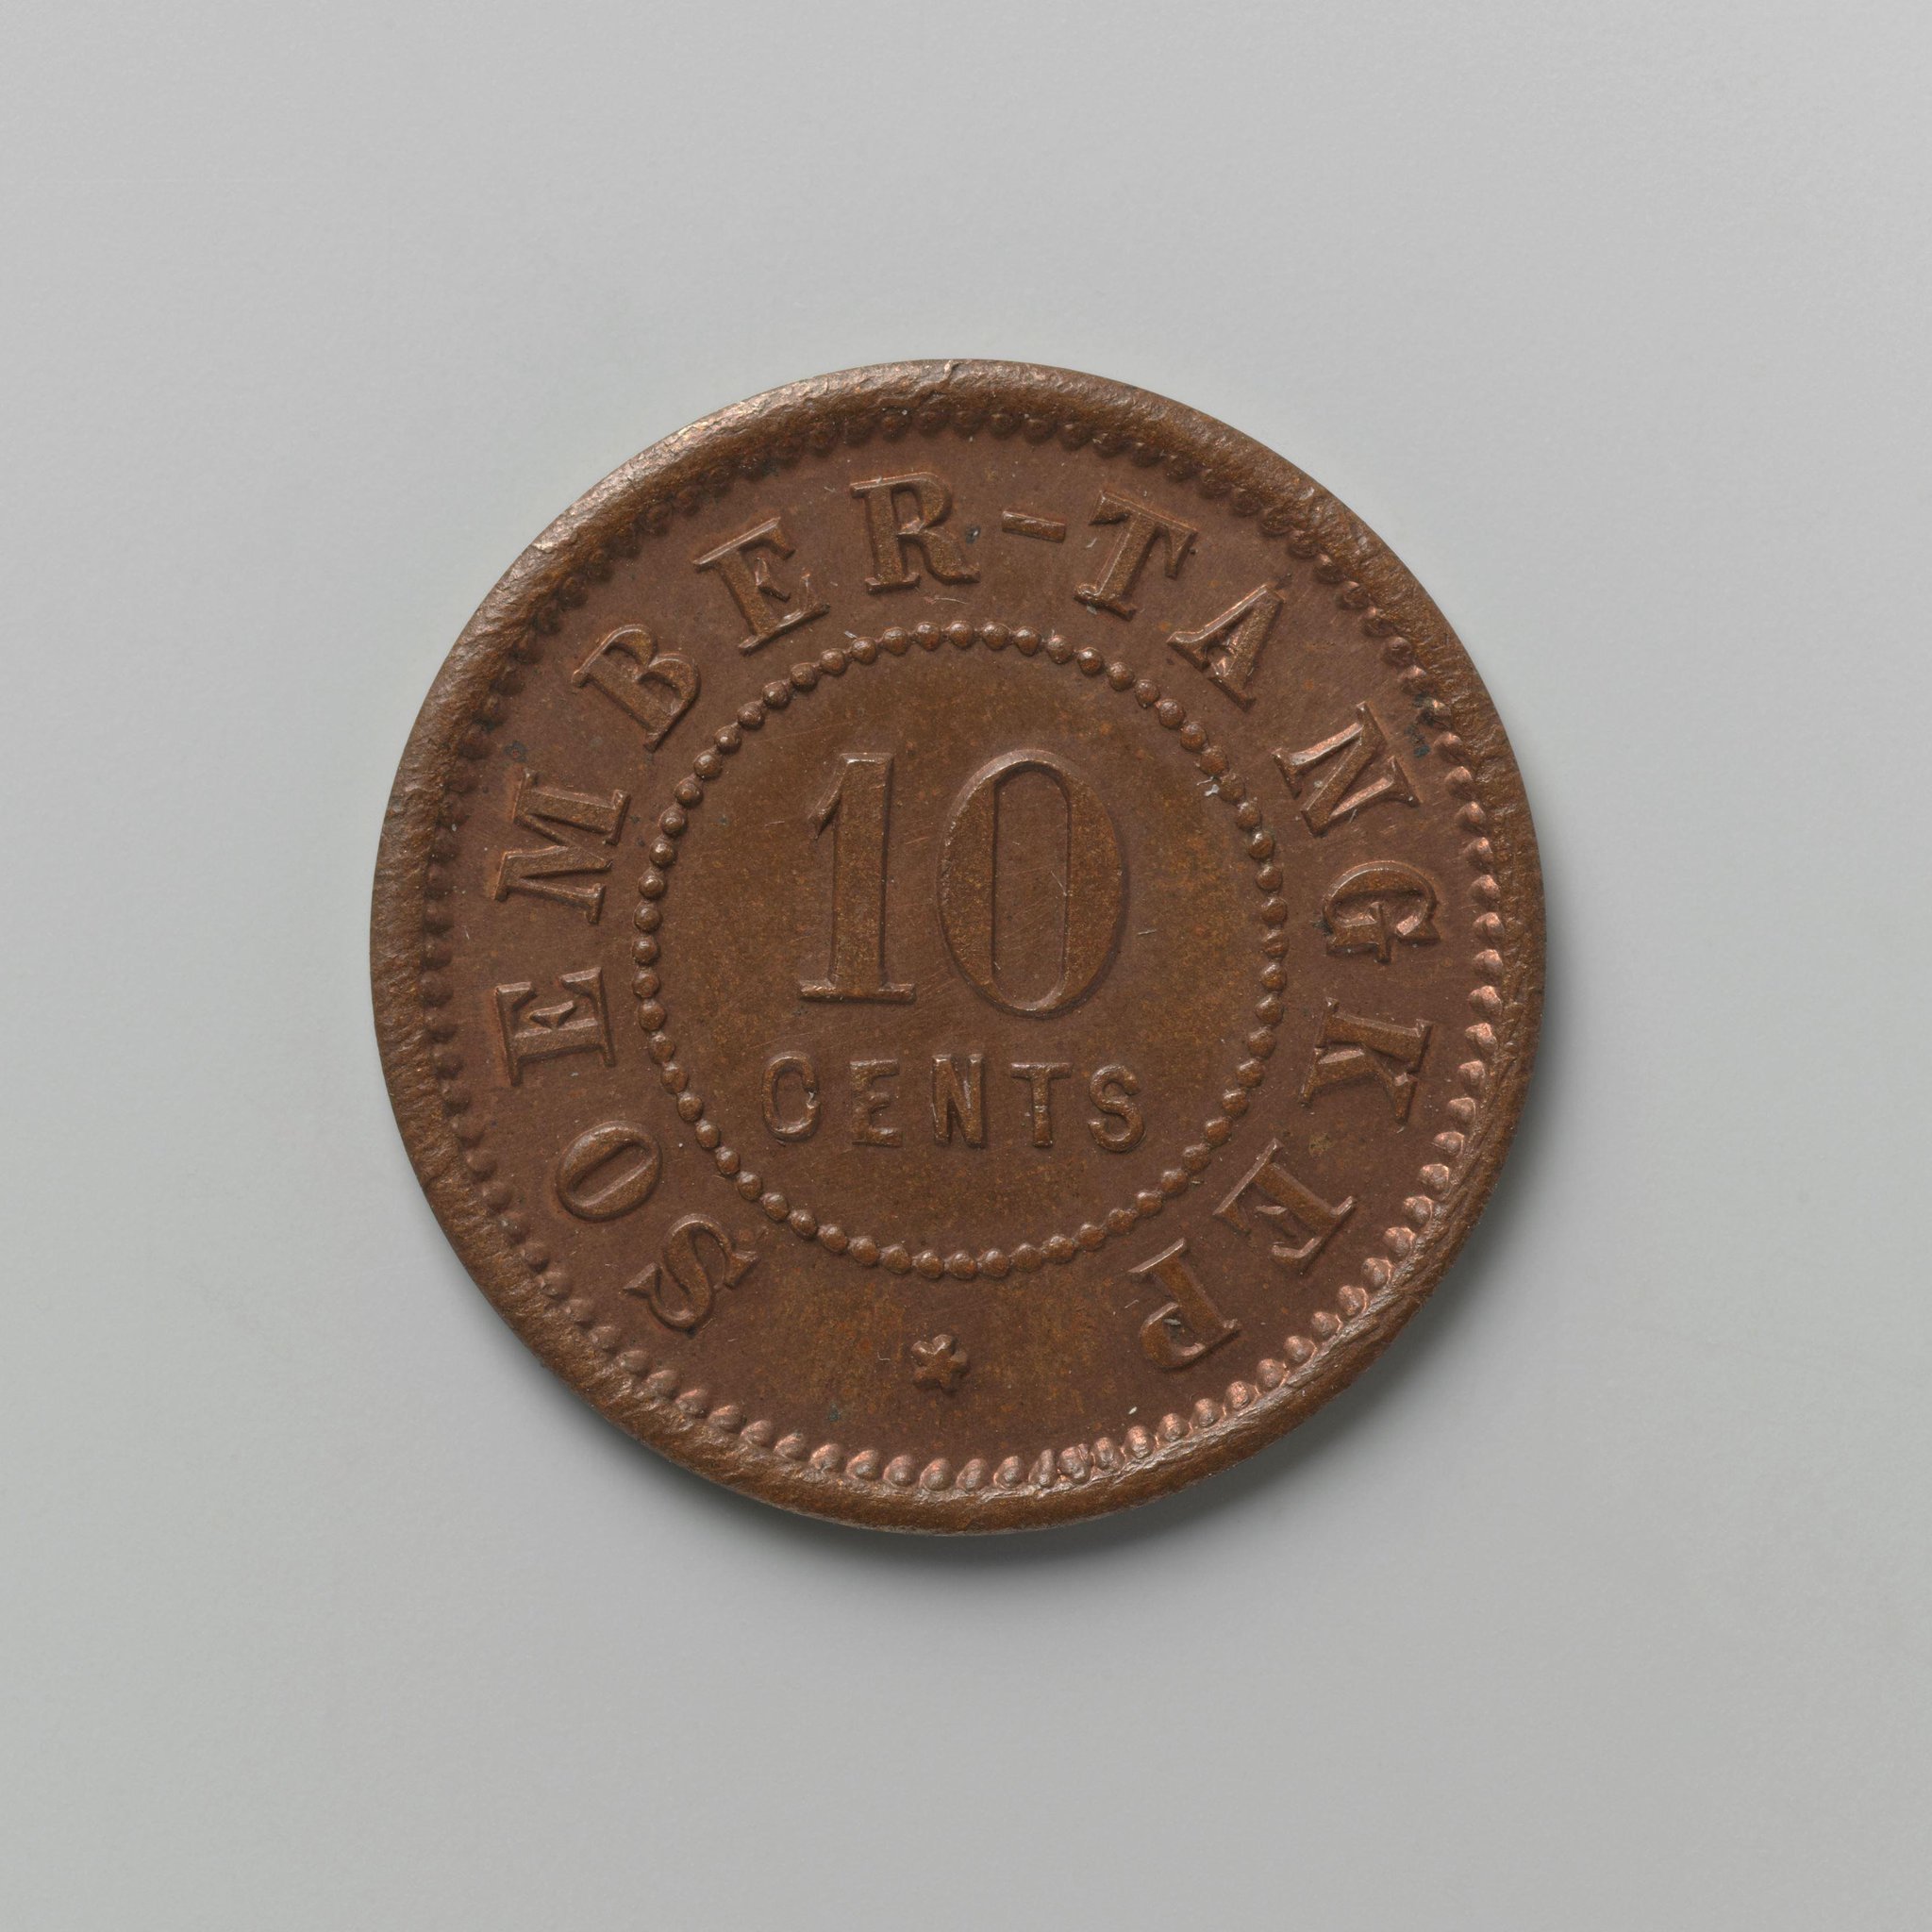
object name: monetary token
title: Tien cents voor plantage Soember-Tangkep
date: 1875-1925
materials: copper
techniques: striking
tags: plantage soember-tangkep, passoeroean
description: Koperen partuculiere munt. Plantage-geld. Voorzijde: in twee regels waarde-aanduiding. In omschrift aanduiding van de plantage. Keerzijde: in twee regels waarde-aanduiding. Gladde rand.